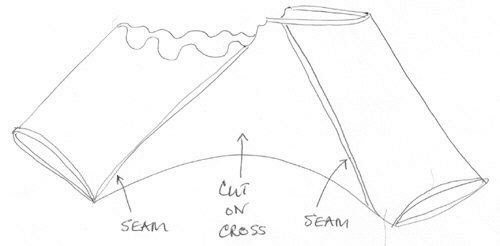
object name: pant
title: Linen pants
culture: alanic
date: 601-900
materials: linen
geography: caucasus